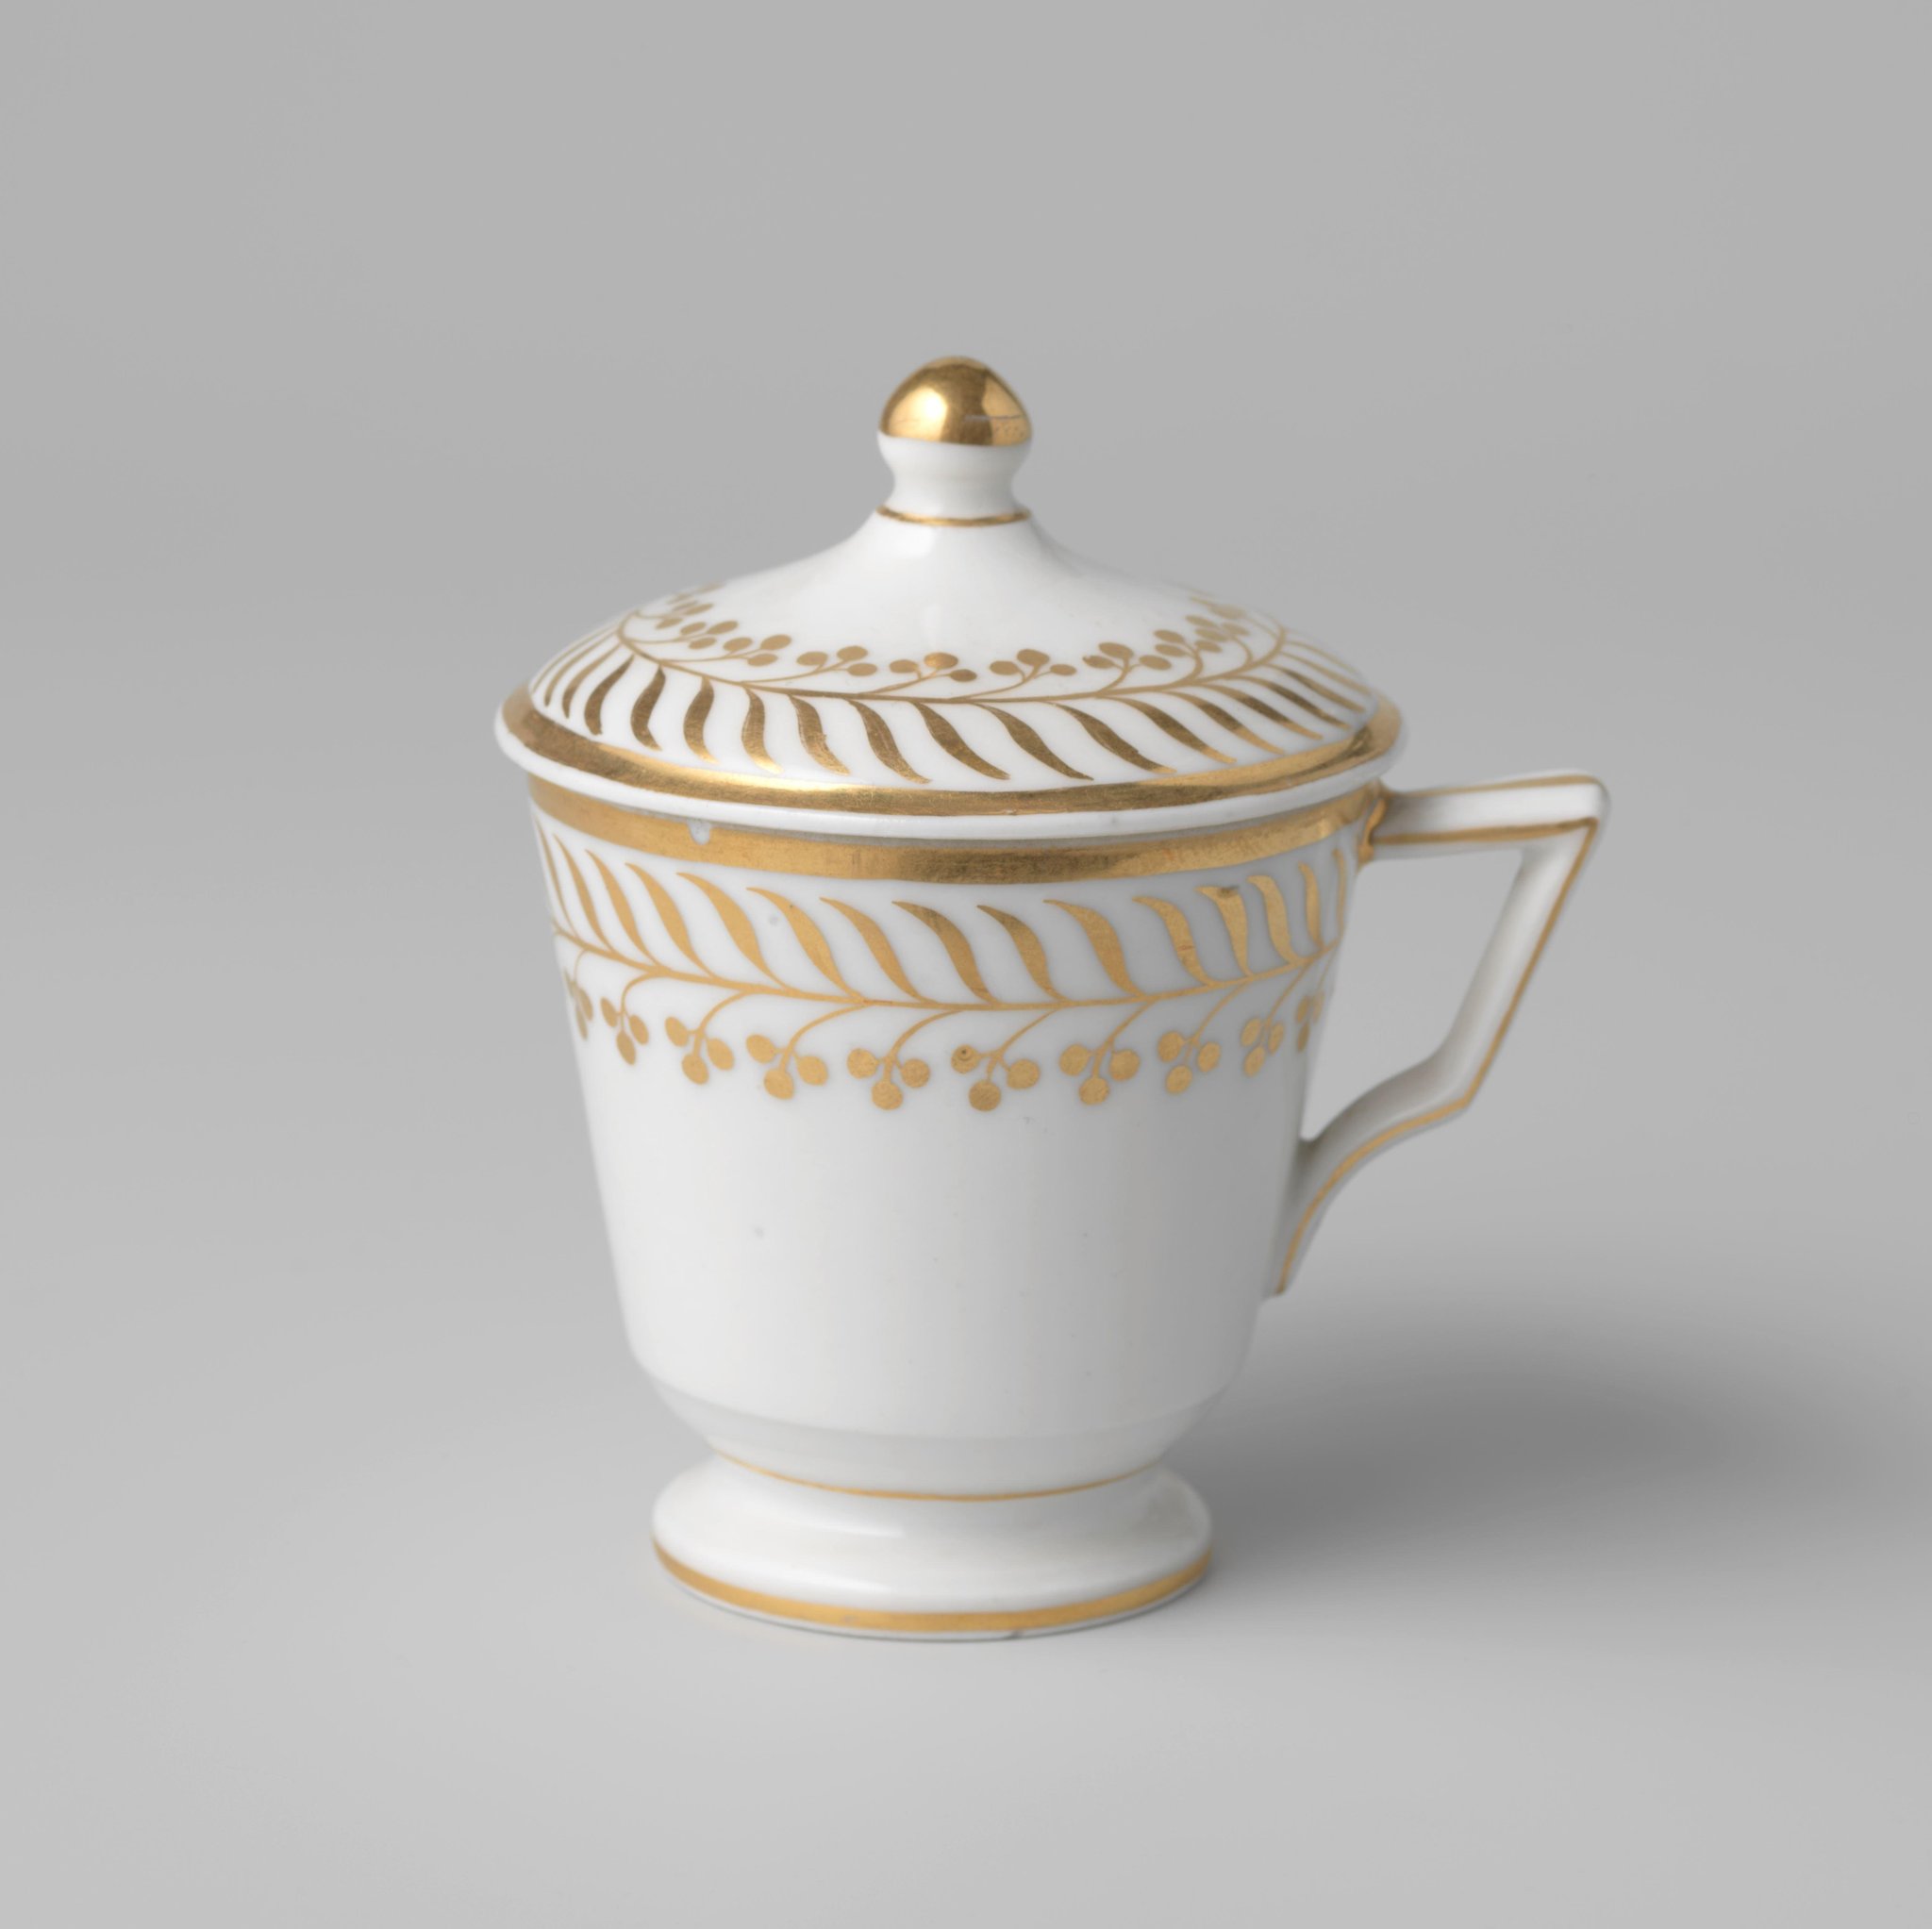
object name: lid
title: Cover of a cup (pot de crème) with stylized floral scrolls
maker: Anonymous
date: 1800-1810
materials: glaze, gold, paint, porcelain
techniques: firing, forming, gilding, vitrification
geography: france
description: Deksel van porselein waarop een vergulde knop. Versierd met gouden biezen en langs de randen beschilderd met een doorlopende tak met aan de ene zijde bladeren, aan de andere zijde steeds een tak met drie vruchten.